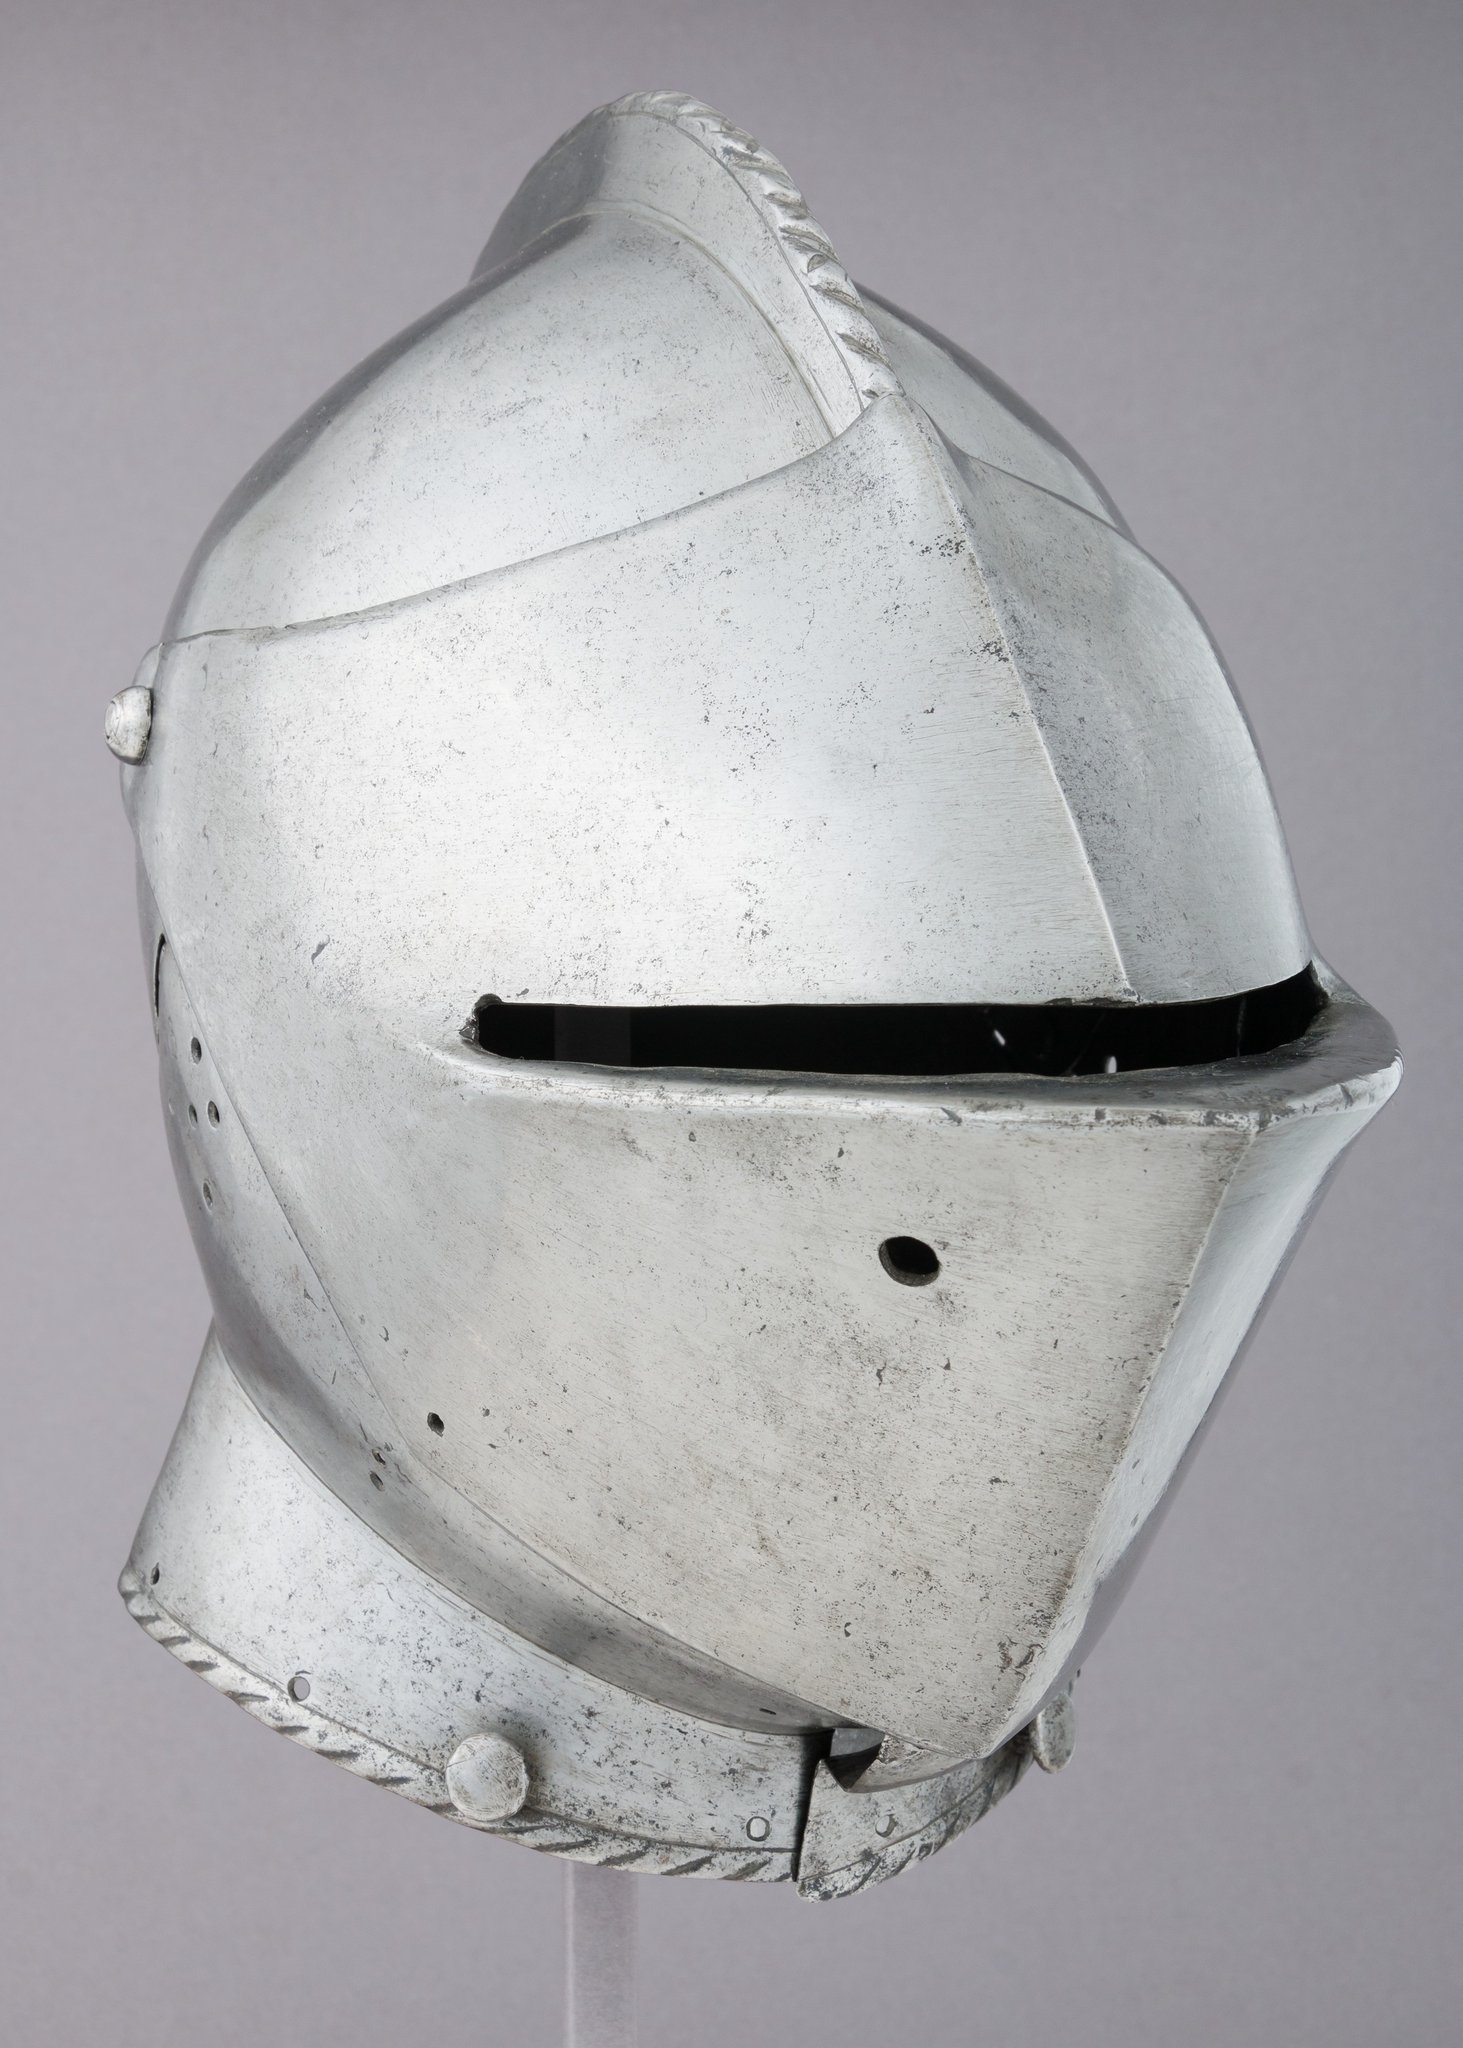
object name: armet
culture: french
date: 1534-1566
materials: steel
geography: france